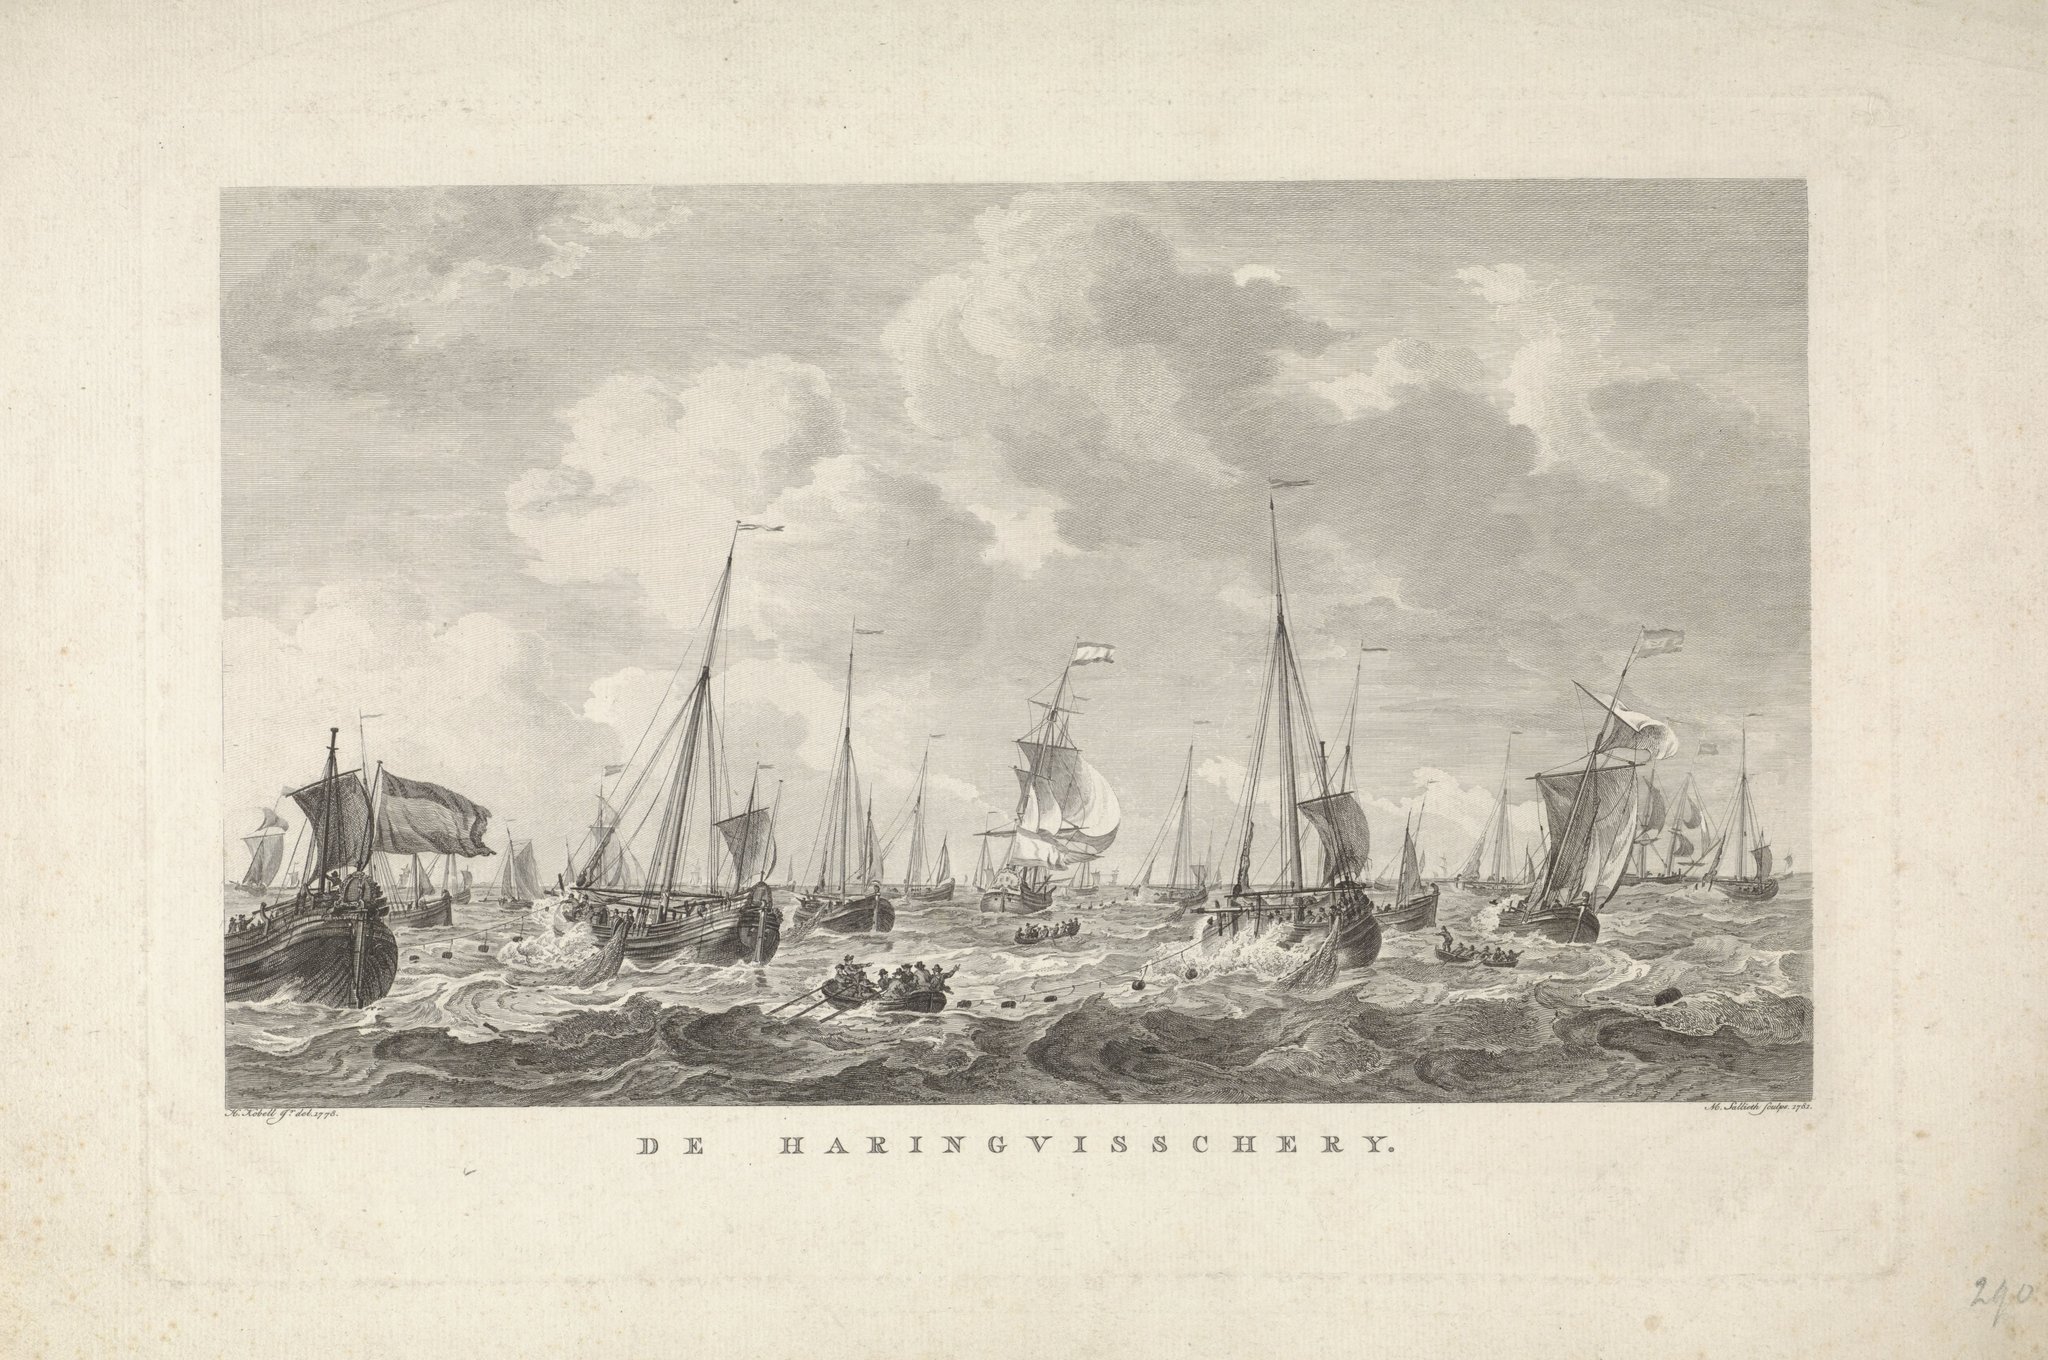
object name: print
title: De Haringvisschery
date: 1781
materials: paper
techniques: engraving, etching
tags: sea and coastal fishery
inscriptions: collector's mark: Lugt 2228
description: Vissersboten die op de Noordzee vissen op haring, 1781.